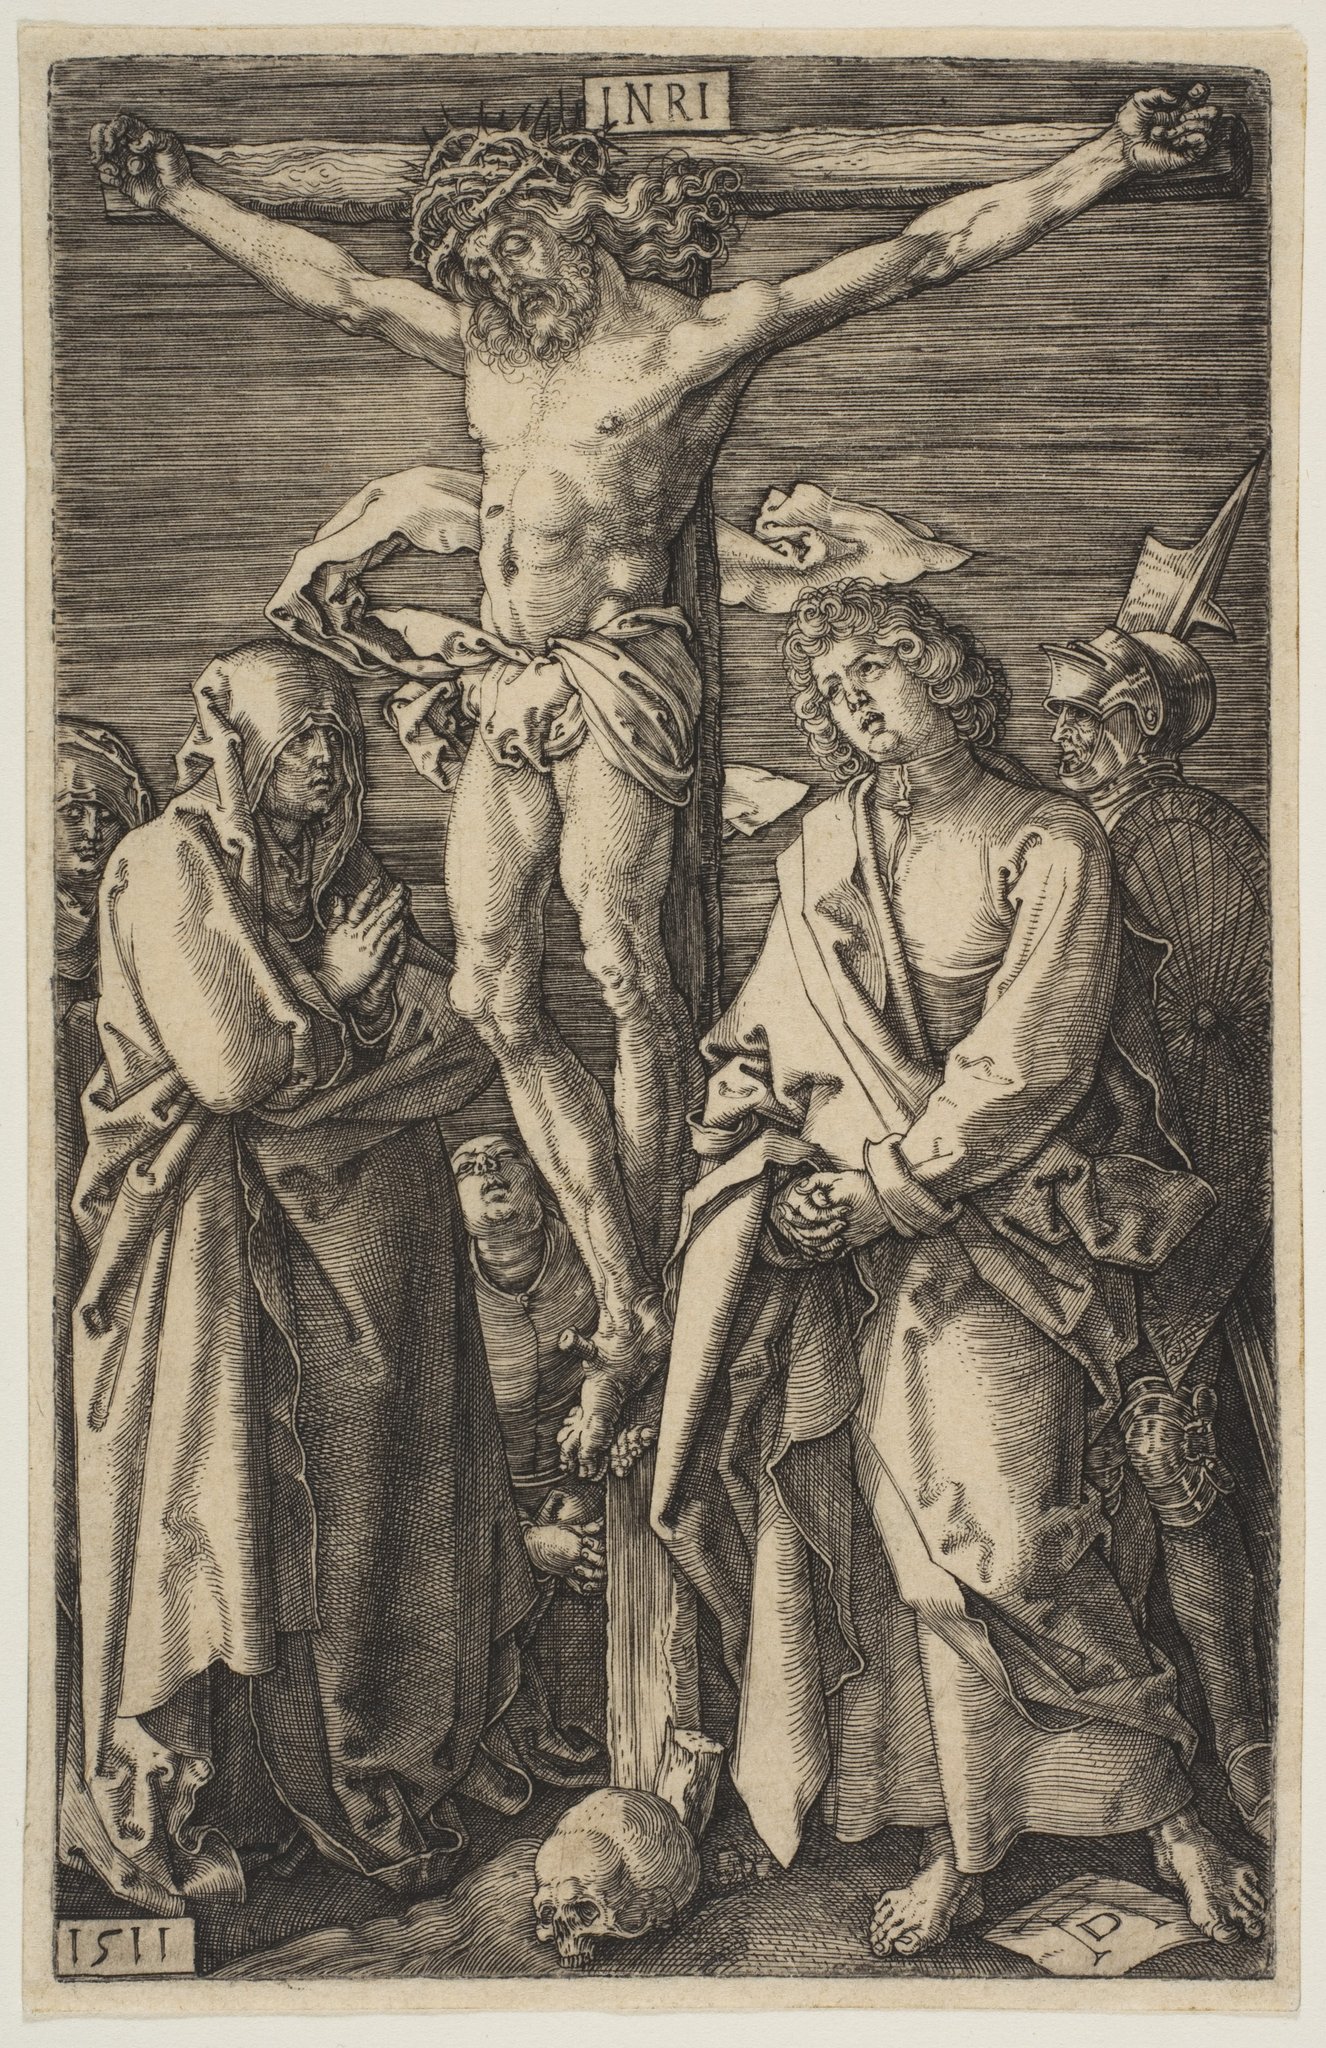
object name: print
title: The Crucifixion, from "The Passion"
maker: albrecht dürer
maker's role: artist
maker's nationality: german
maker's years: 1471-1528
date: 1511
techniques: engraving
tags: men,women,christ,crucifixion